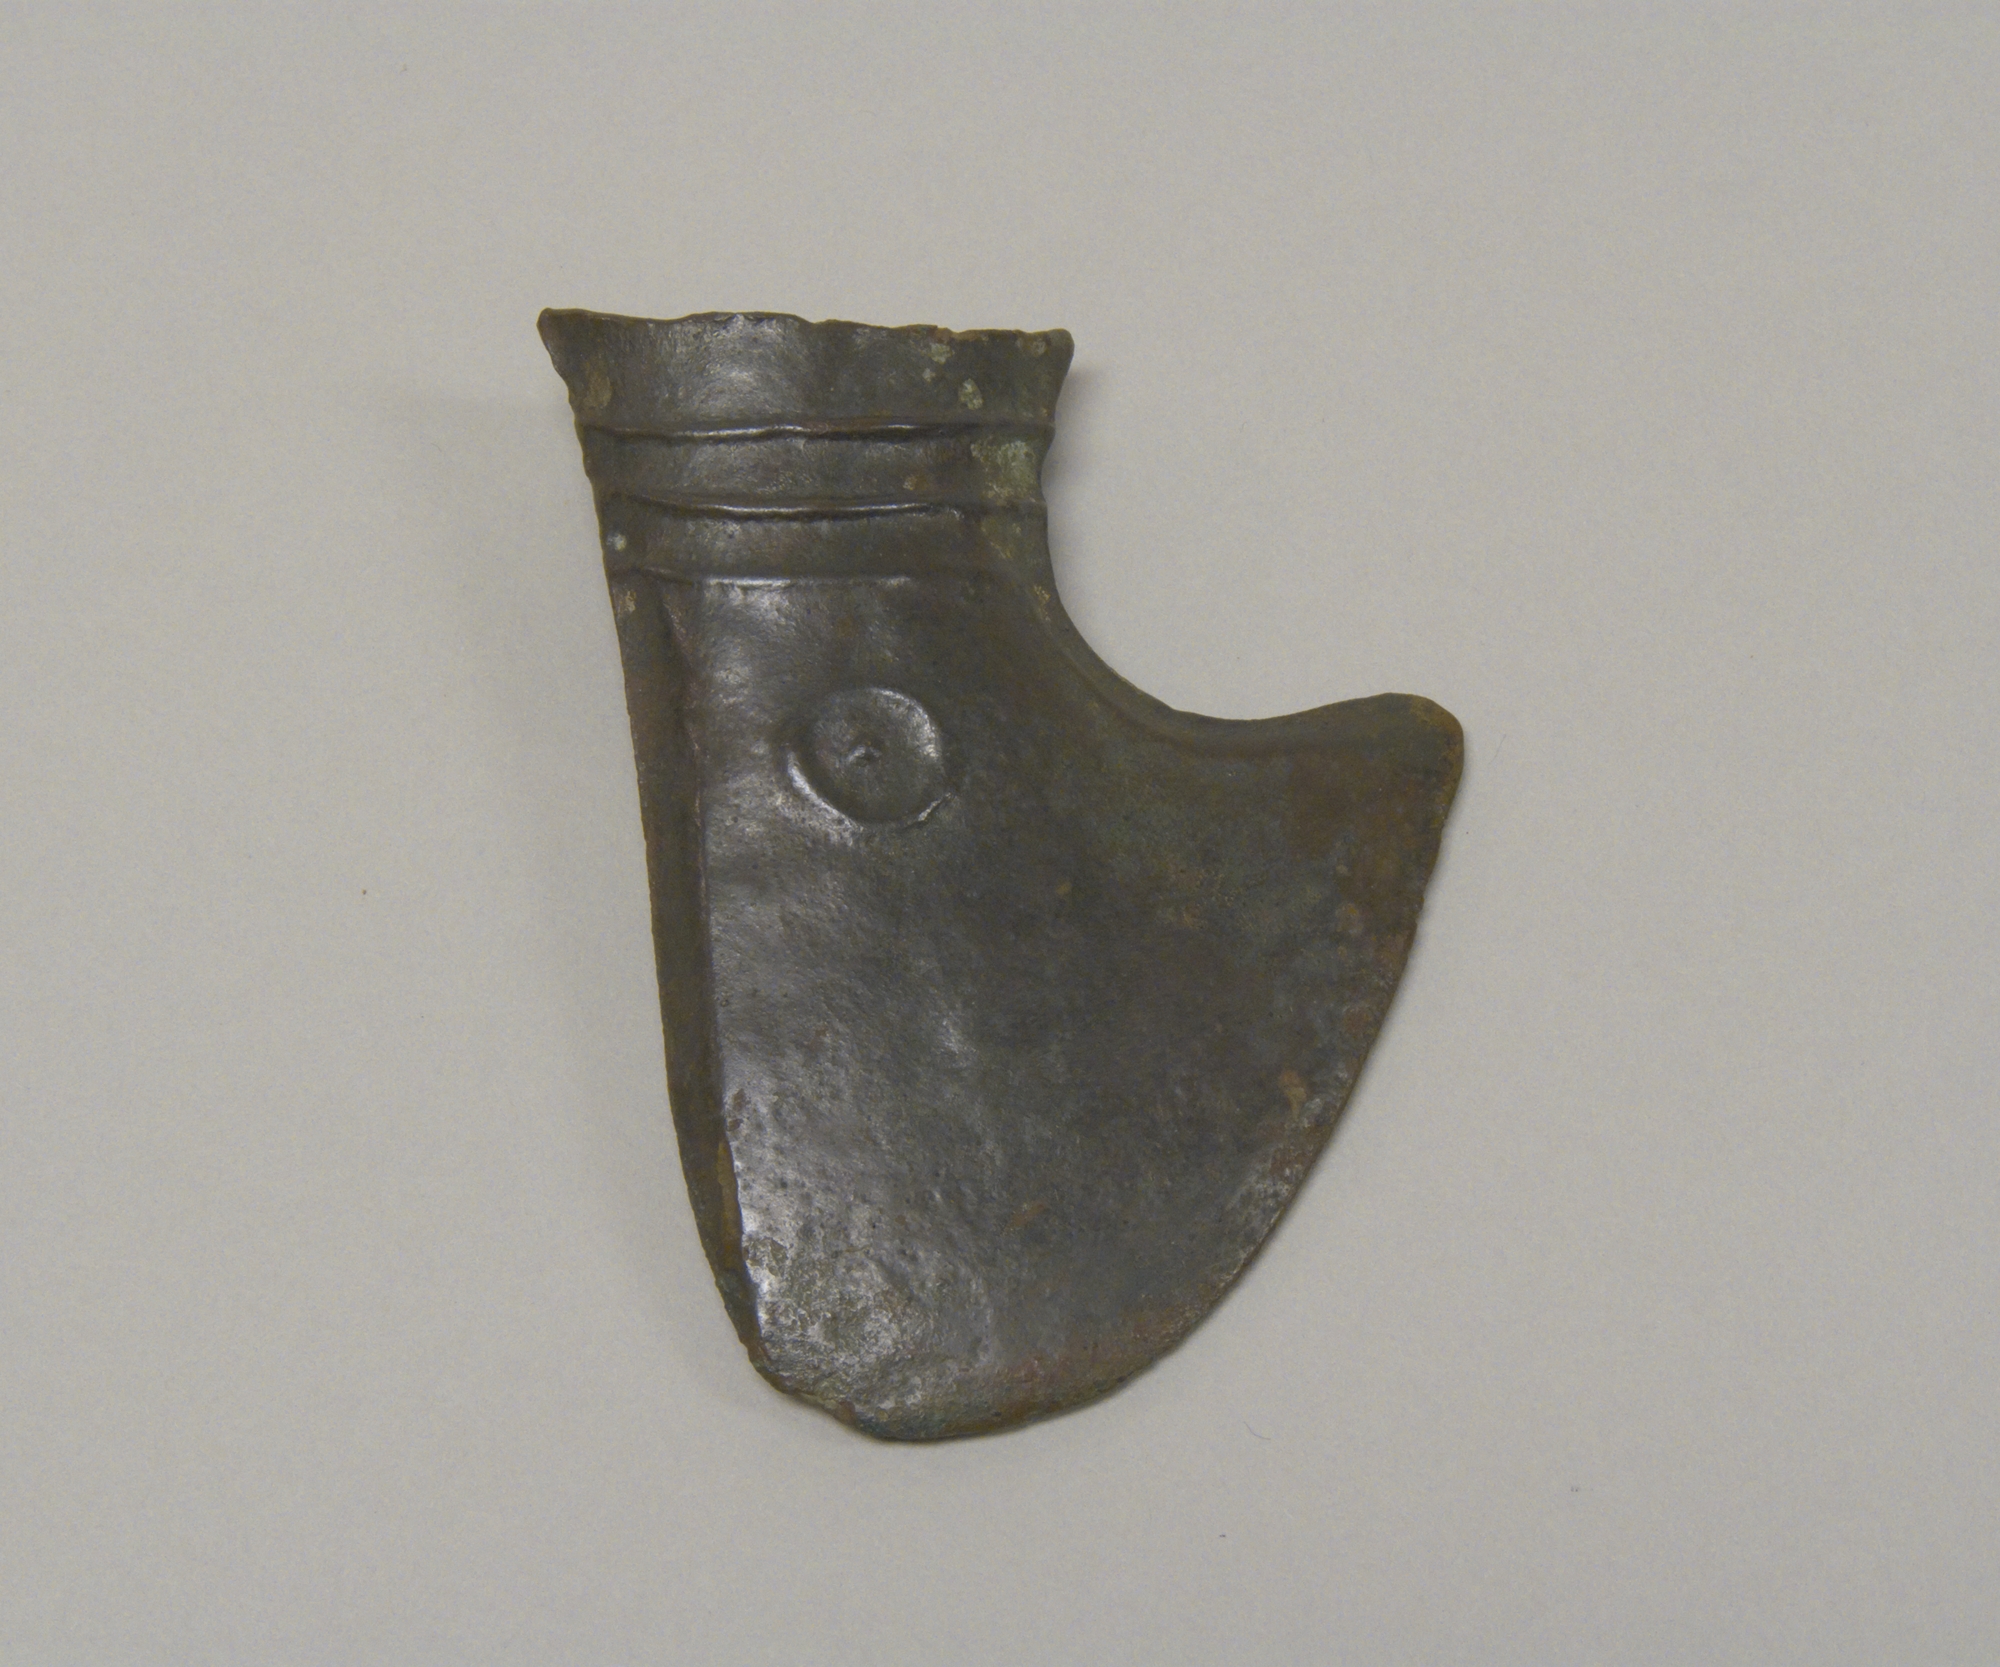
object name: hafted ax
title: Asymmetric Pediform Hafted Ax with Eye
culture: vietnamese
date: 500 BCE-300 CE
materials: bronze